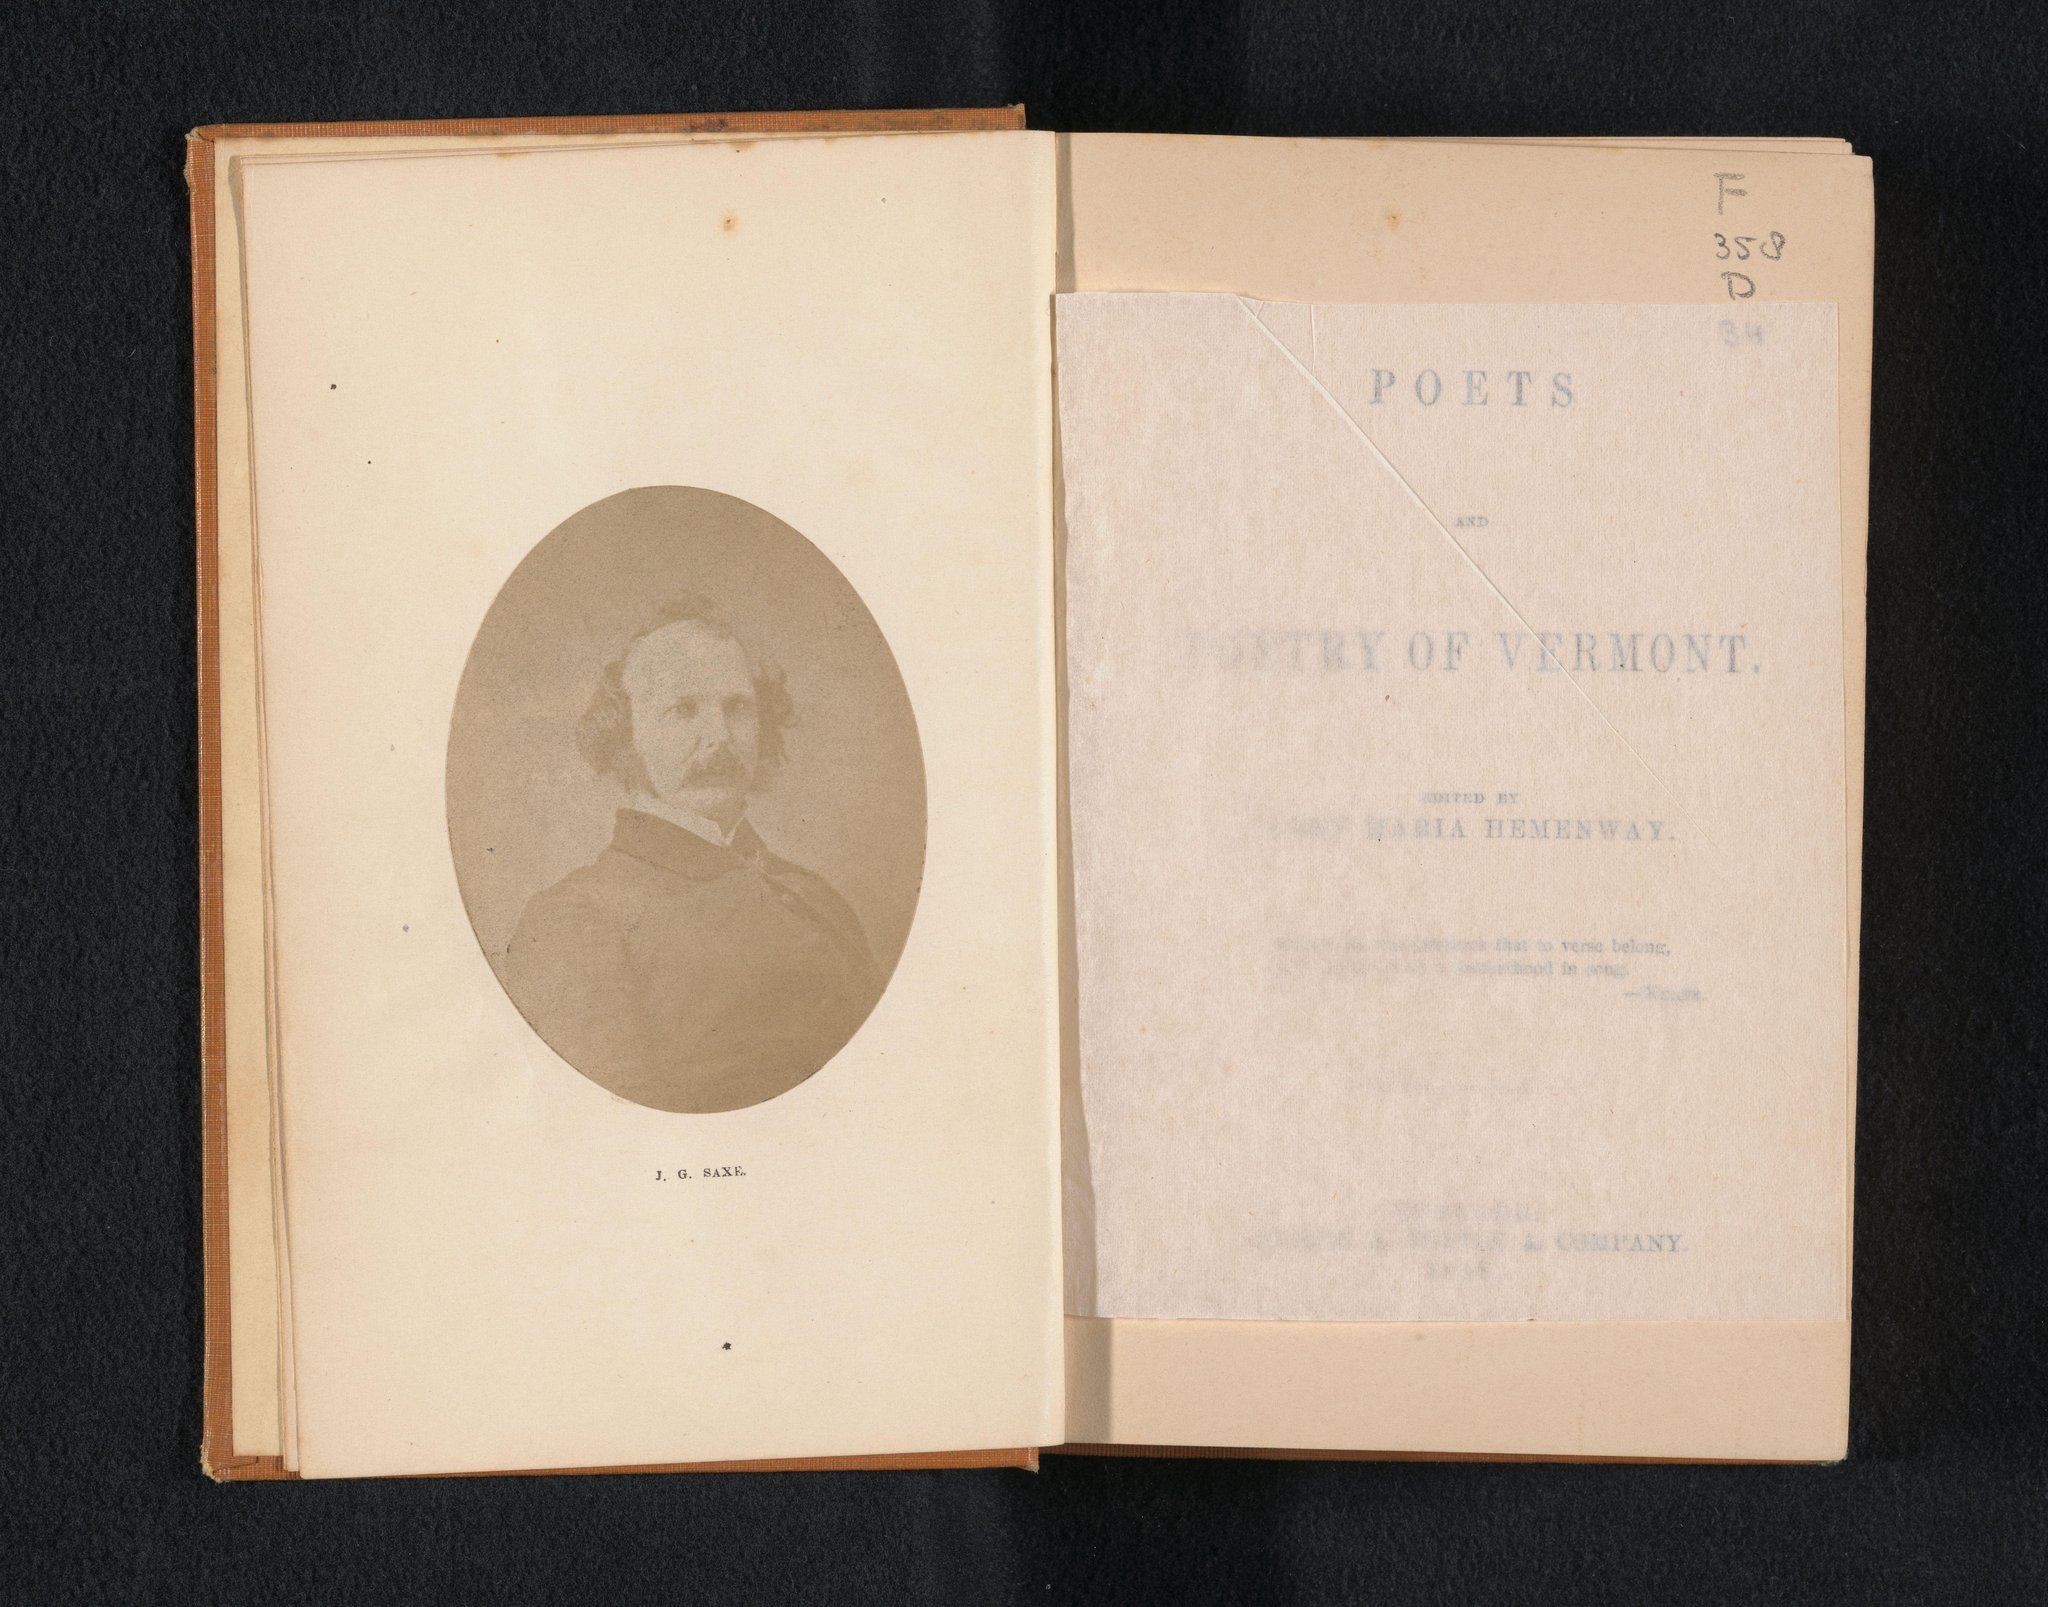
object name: page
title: J.G. Saxe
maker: Anonymous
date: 1853-1858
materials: photographic support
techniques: salted paper print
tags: portrait of a writer